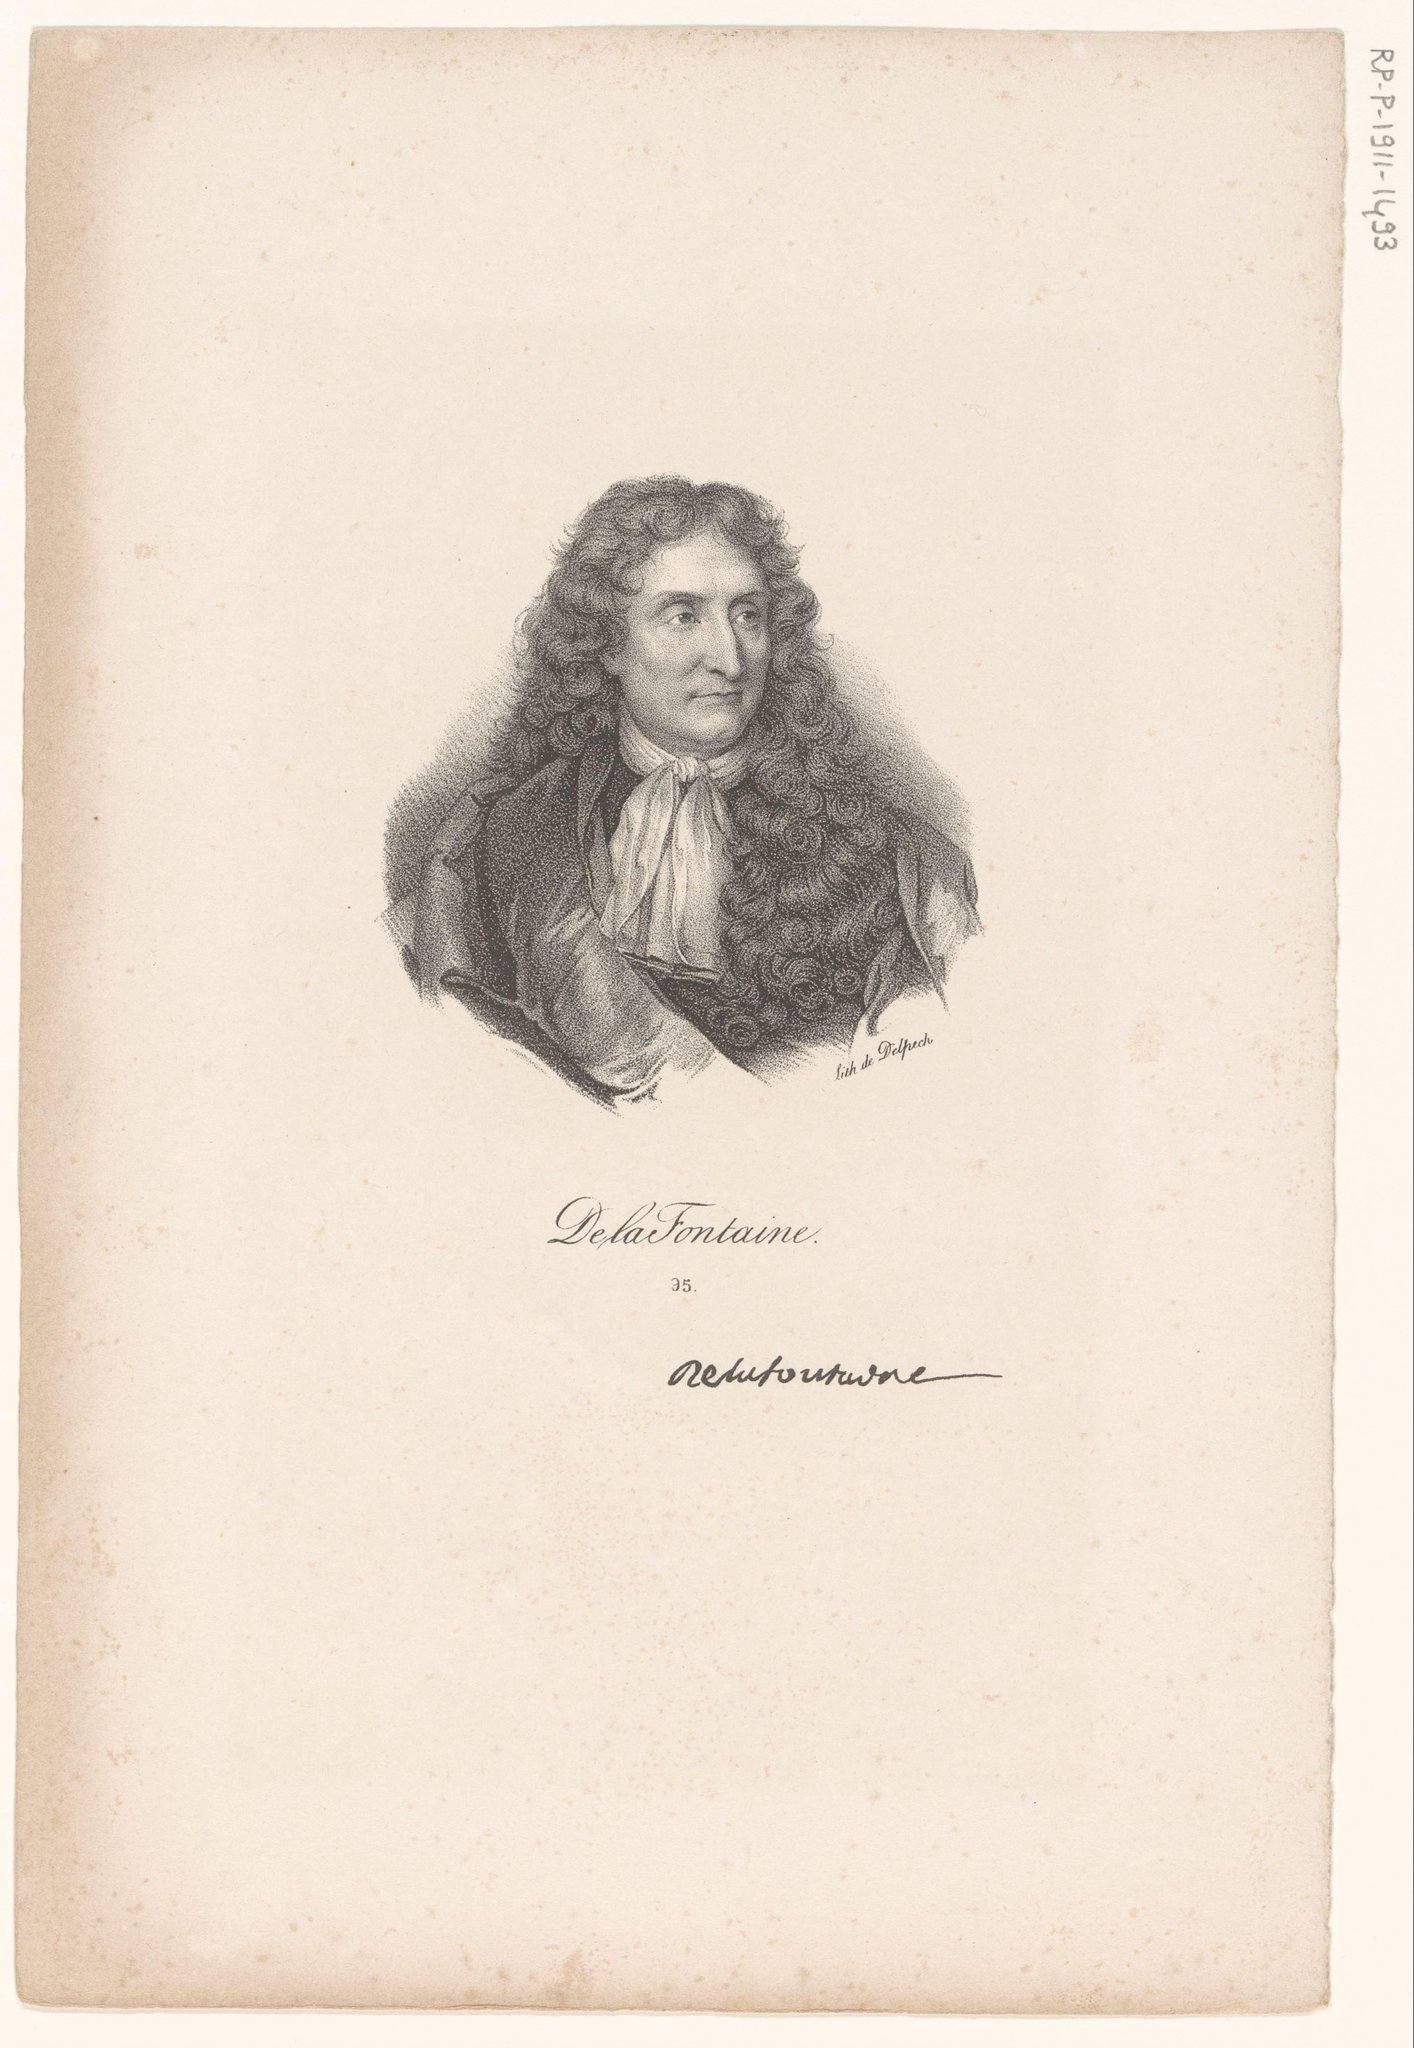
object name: print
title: Portret van De la Fontaine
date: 1818-1842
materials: paper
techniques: lithograph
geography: paris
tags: paris, jean de la fontaine, historical persons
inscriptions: collector's mark: Lugt 2228a